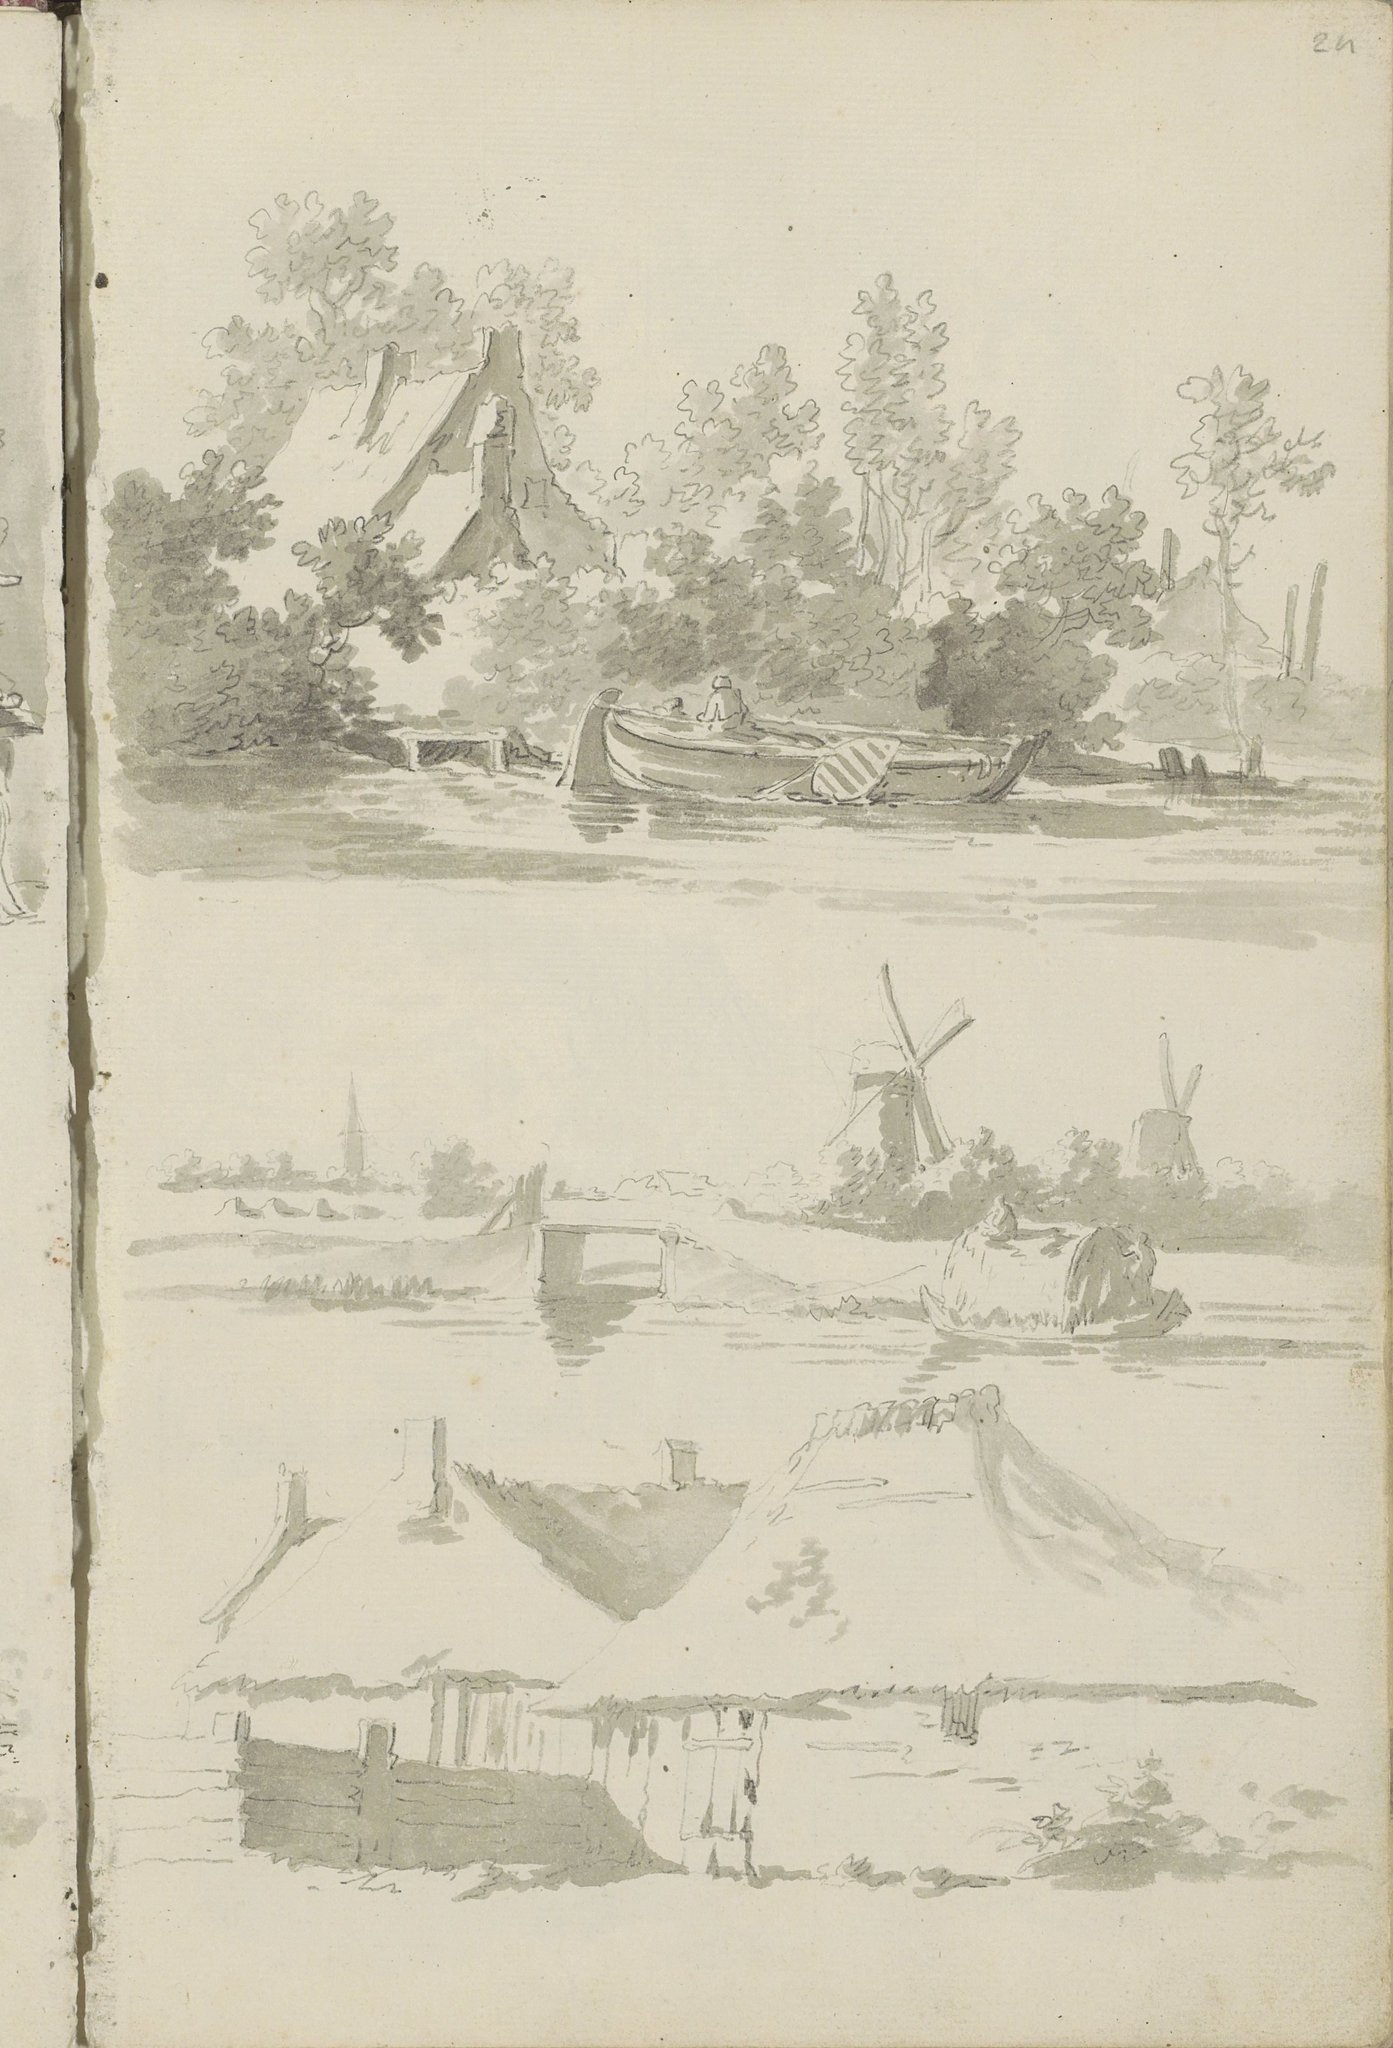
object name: sketchbook leaf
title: Riviergezichten en een boerderij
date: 1780-1800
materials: paper, pencil, watercolor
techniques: brush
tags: river, farm (building)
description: Blad 7 recto uit een schetsboek met 25 bladen.